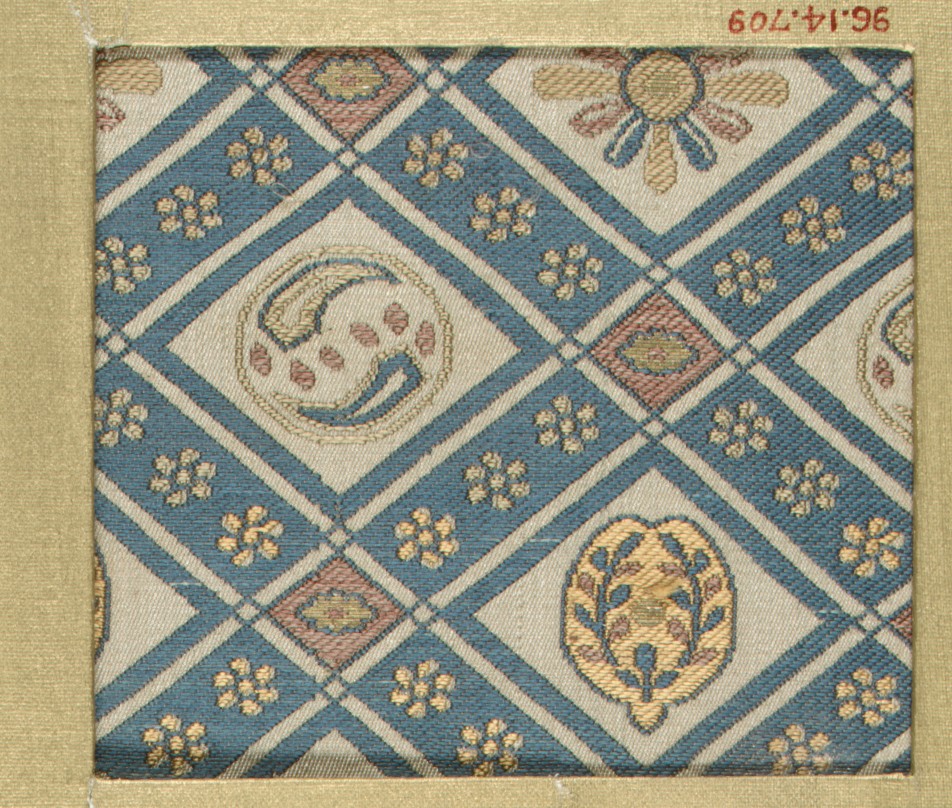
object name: piece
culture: japanese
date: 1701-1900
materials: silk